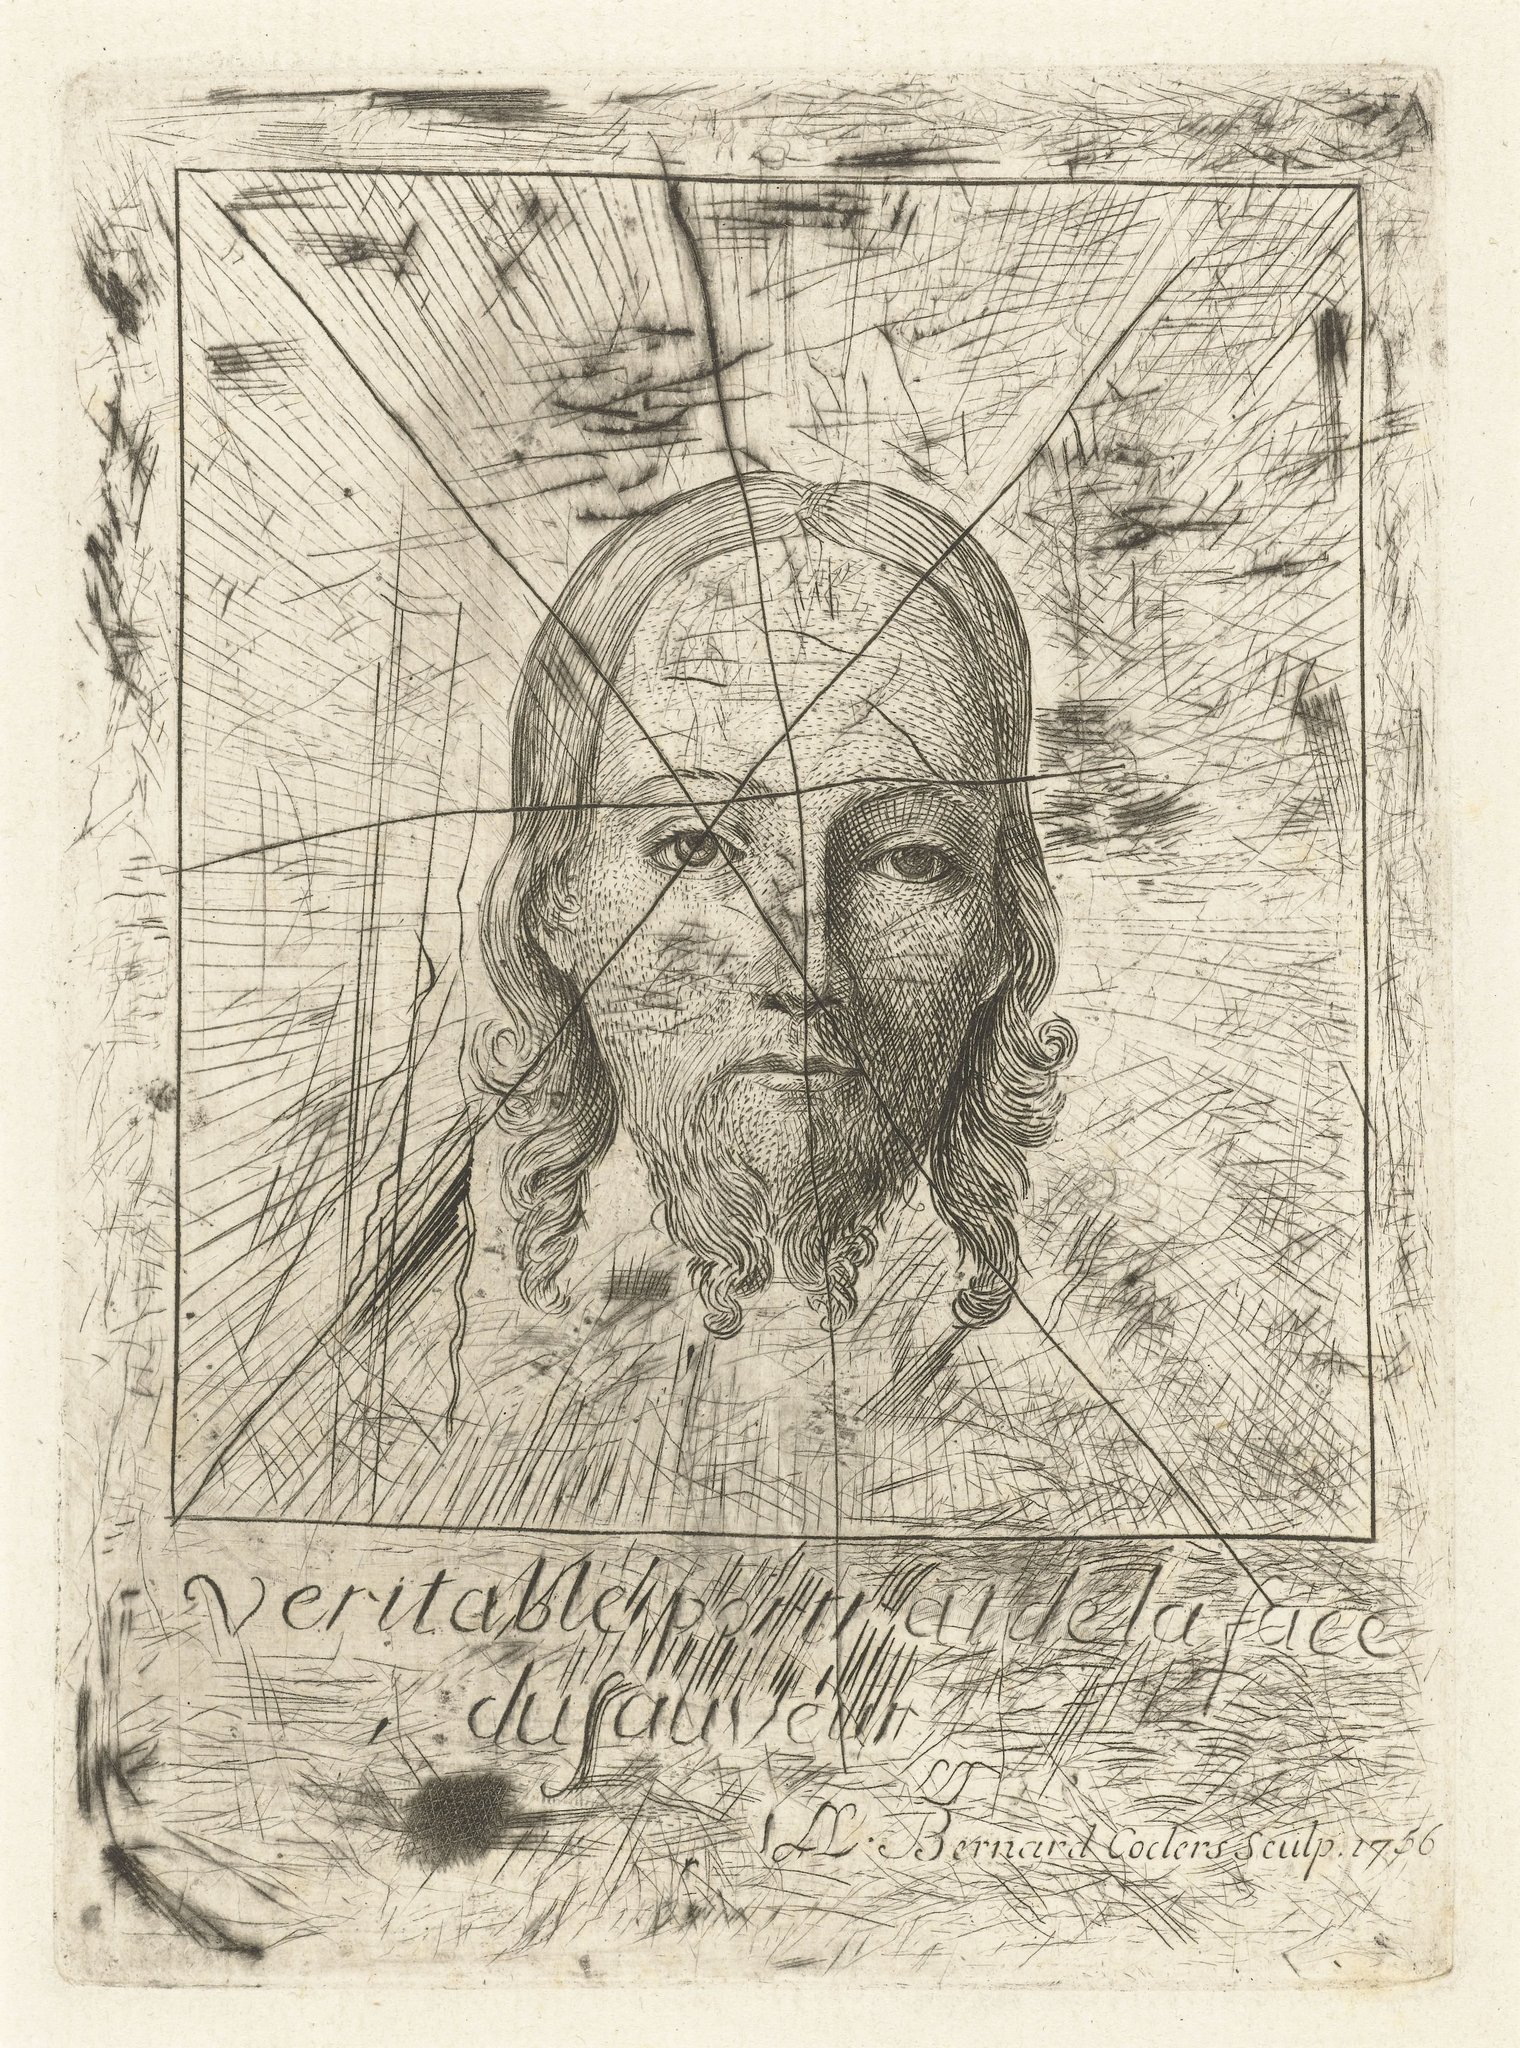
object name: print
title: Hoofd van Christus in stralenkrans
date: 1756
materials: paper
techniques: drypoint, engraving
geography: maastricht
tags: portrait of christ made by luke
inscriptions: collector's mark: Lugt 2228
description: Het hoofd van Christus, met lang haar en baard in een stralenkrans. Met onderschrift in het Frans. De plaat is gebruikt als oefenplaat voor de etsnaald.